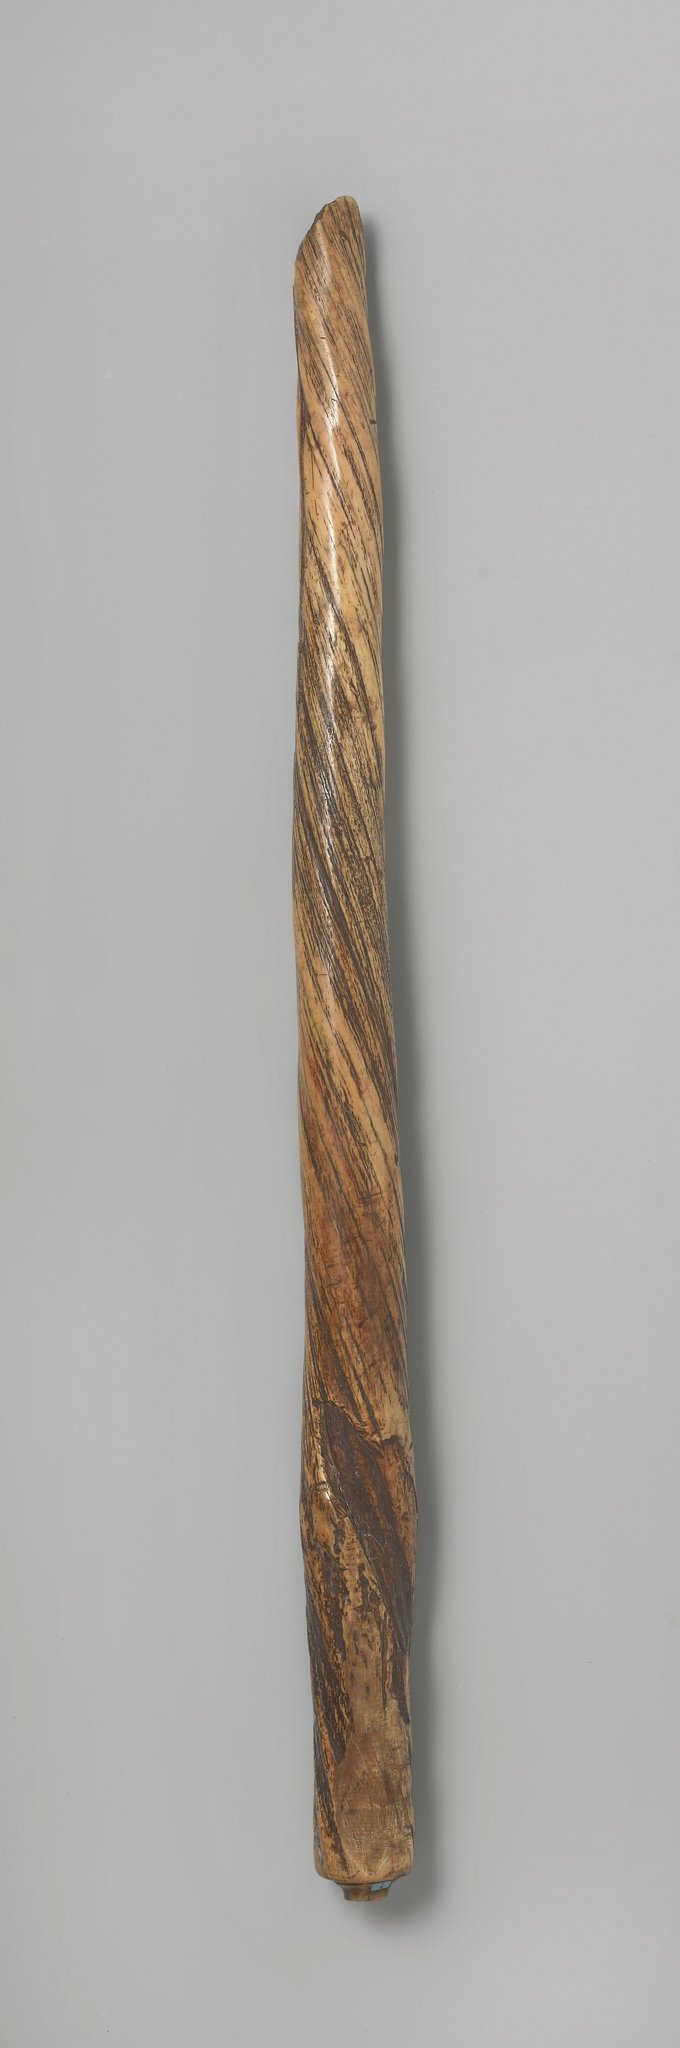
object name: tooth material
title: Unicorn horns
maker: Anonymous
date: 1000-1099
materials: ivory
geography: northwest europe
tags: utrecht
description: For centuries, these three objects appeared on Catholic feast days on the high altar of the Mariakerk, Utrecht. Candlesticks were placed on their pointed ends. People believed the horns were those of a unicorn, a mythical creature then regarded as a symbol of the Virgin’s chastity. They are, in actual fact, the teeth of a narwhal, a type of whale.